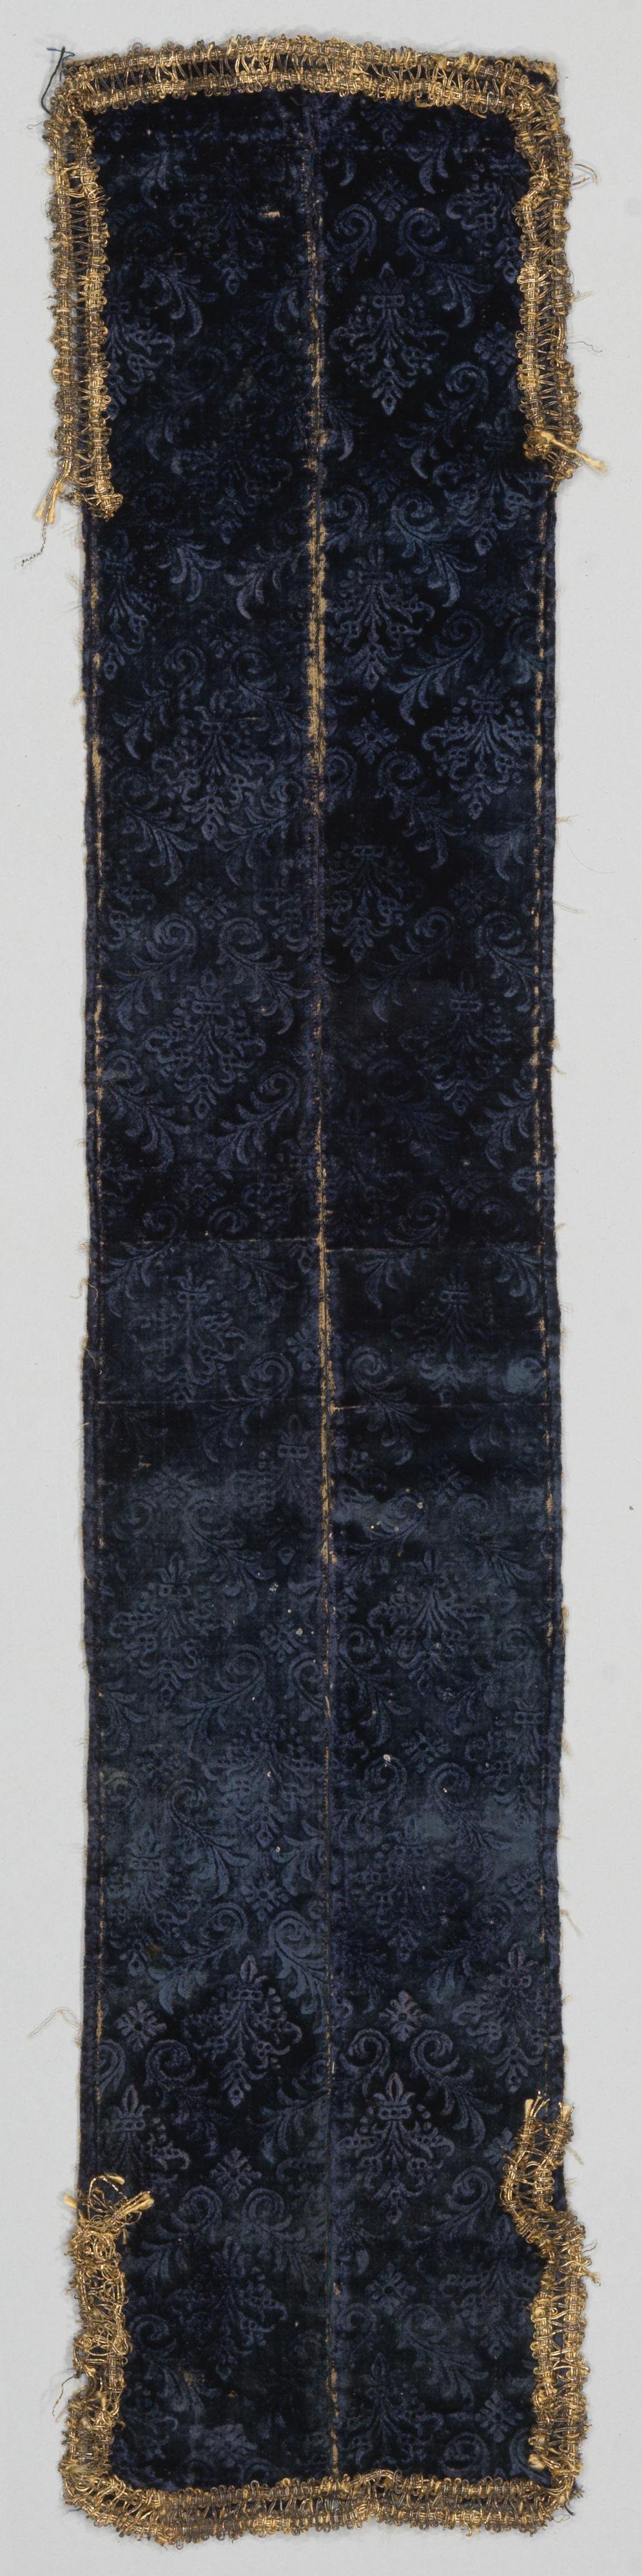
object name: strip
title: Loper, vervaardigd uit twee smalle aan elkaar genaaide stroken donkerblauwe zijdefluweel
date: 1600-1650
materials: linen, silk, velvet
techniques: pressing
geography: north europe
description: Loper, vervaardigd uit twee smalle aan elkaar genaaide stroken donkerblauwe zijdefluweel met ingeperst dessin van bladranken in ruitpatroon waarbinnen een boeket. Gevoerd met grijsblauw linnen.